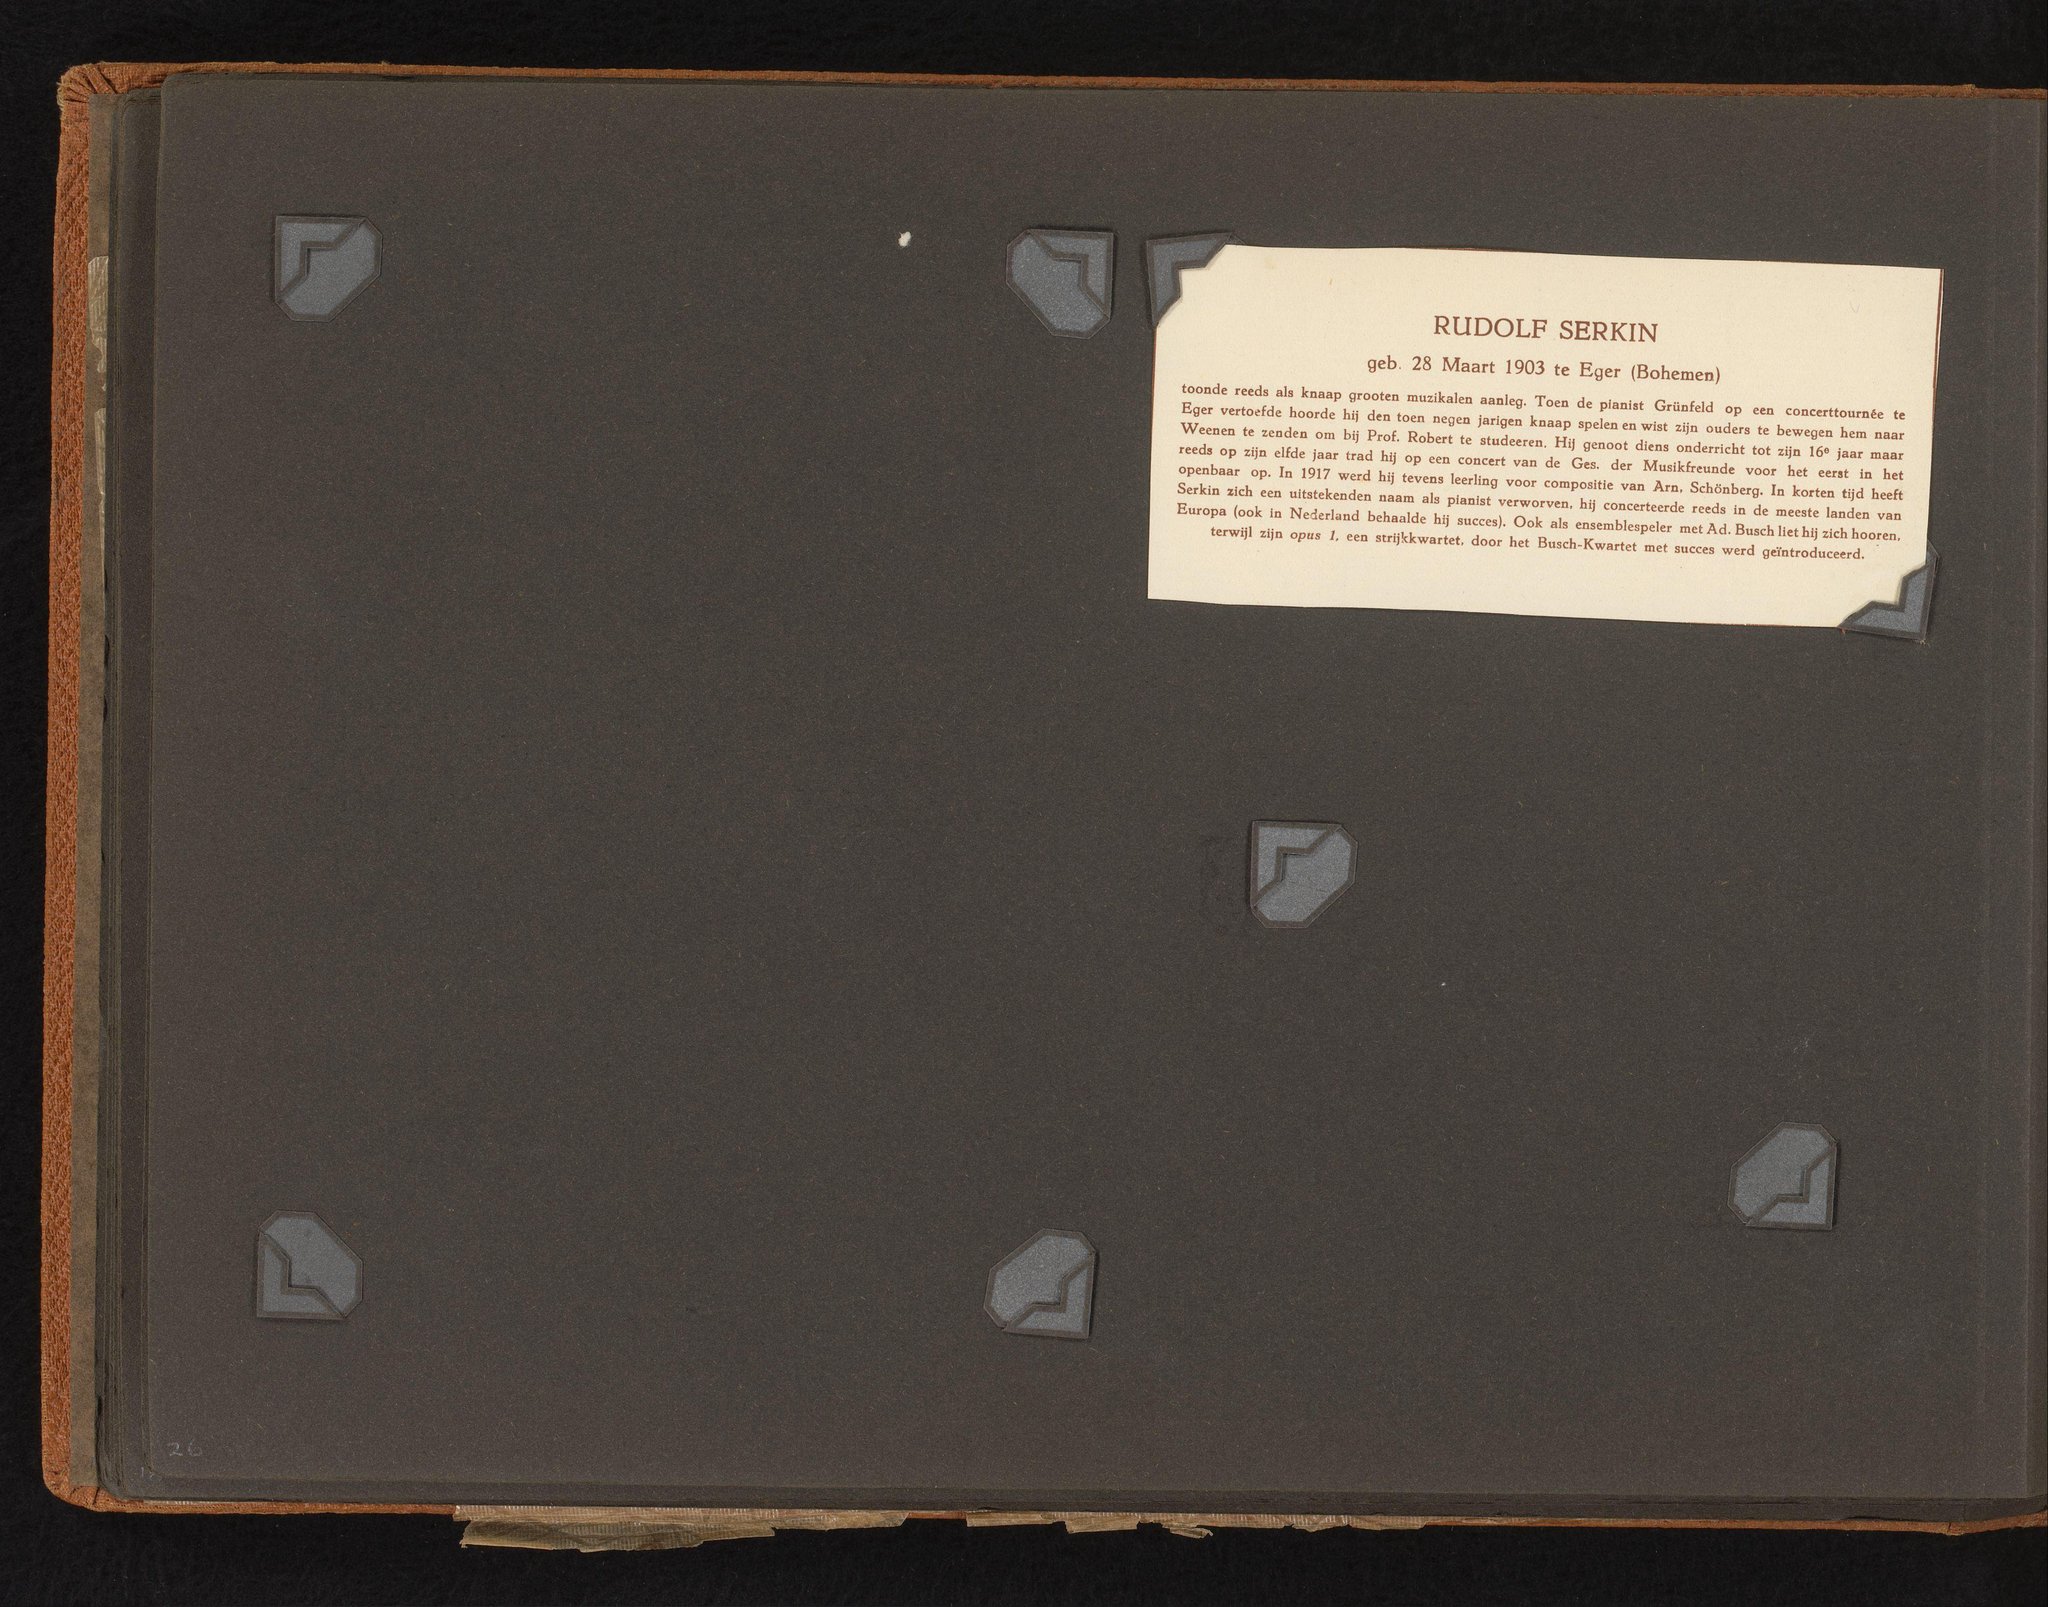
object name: album leaf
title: Rudolf Serkin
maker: Anonymous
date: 1933-1936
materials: paper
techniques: printed materials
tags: portrait of a musician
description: Albumblad met een tekst over de pianist Rudolf Serkin. Onderdeel van het Esperanto album uit ca. 1933-1936.